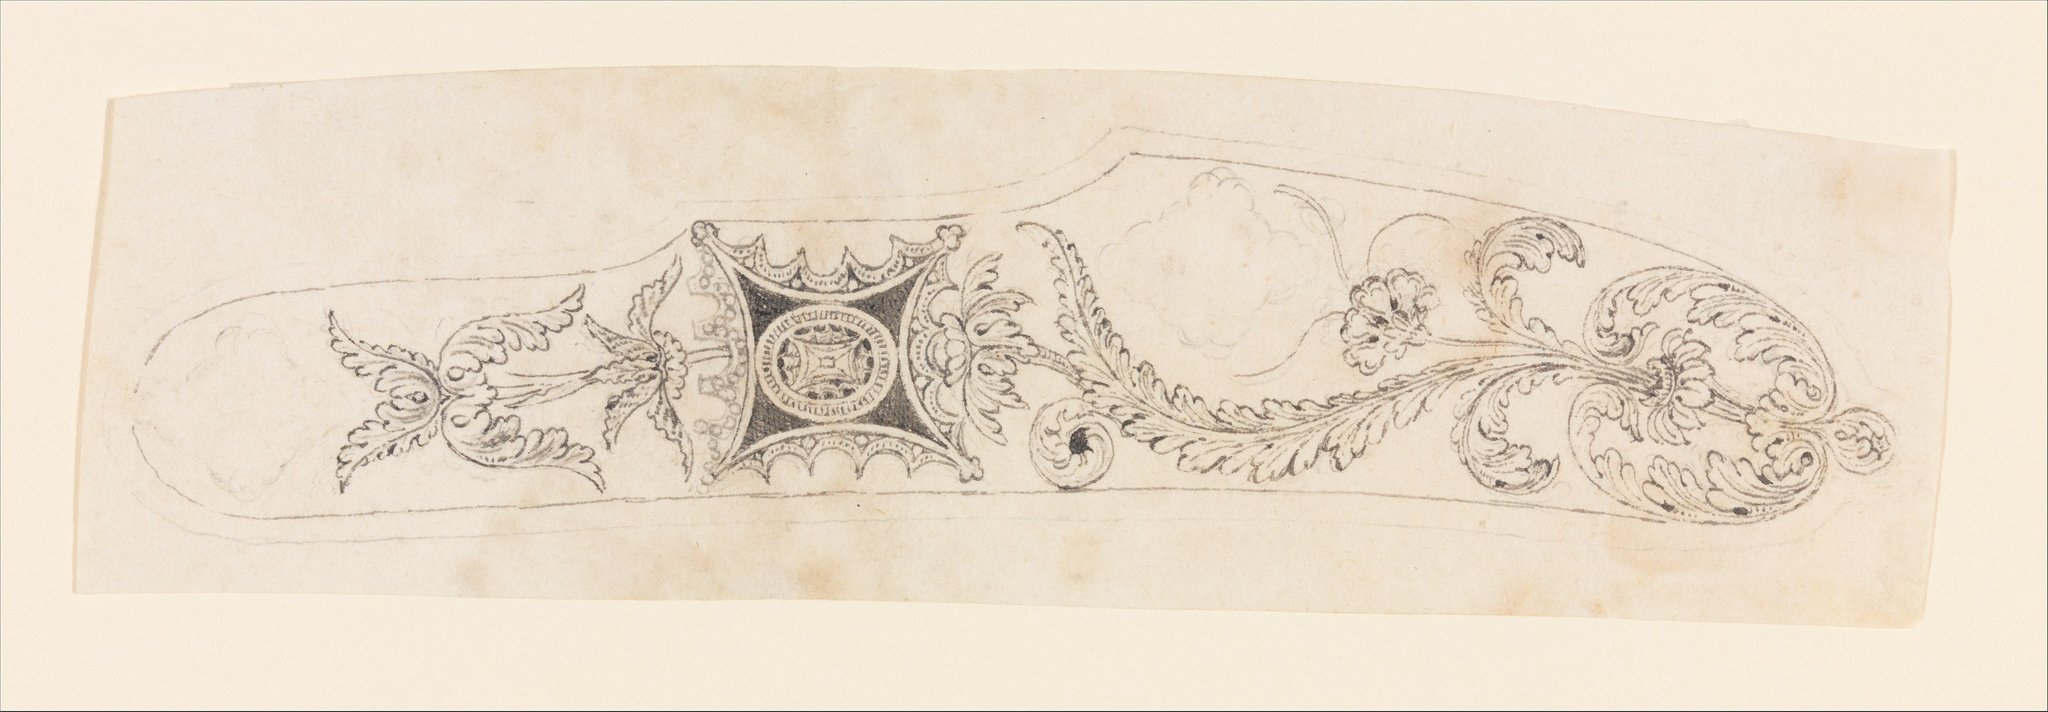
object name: drawing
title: Design for the Decoration of the Side Plate of a Firearm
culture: french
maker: nicolas noël boutet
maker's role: designer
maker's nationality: french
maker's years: 1761-1833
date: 1797-1805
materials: ink, paper, pencil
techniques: wash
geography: france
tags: ornament